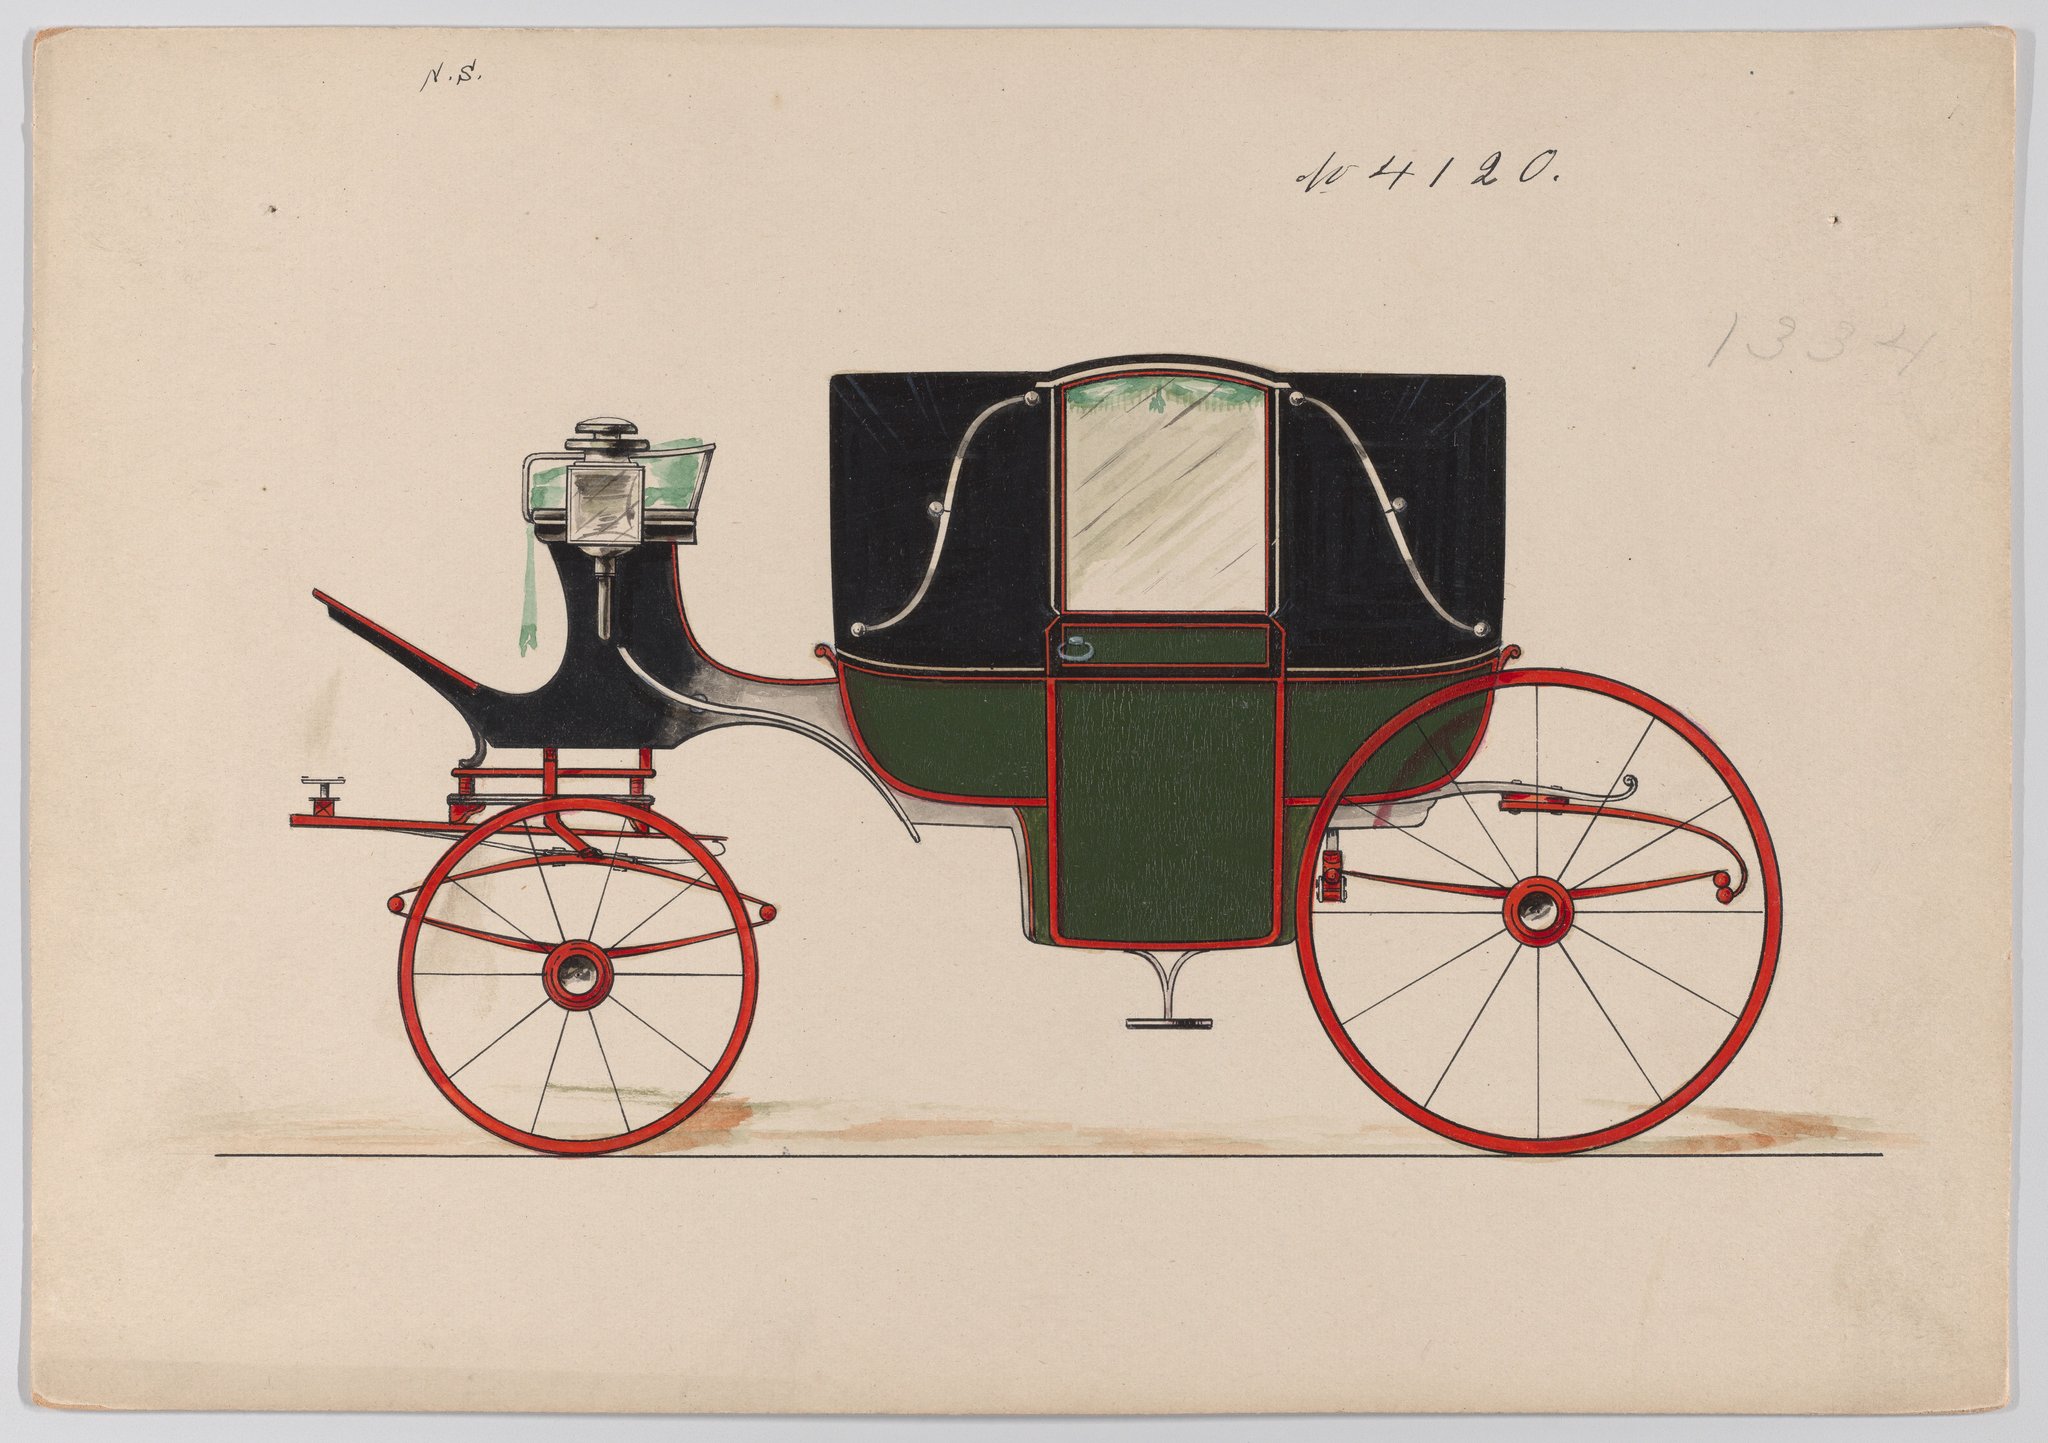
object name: drawing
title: Design for Landau, No. 4120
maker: brewster & co.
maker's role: manufacturer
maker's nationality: american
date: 1891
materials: gouache, gum arabic, ink, watercolor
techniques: pen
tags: carriages